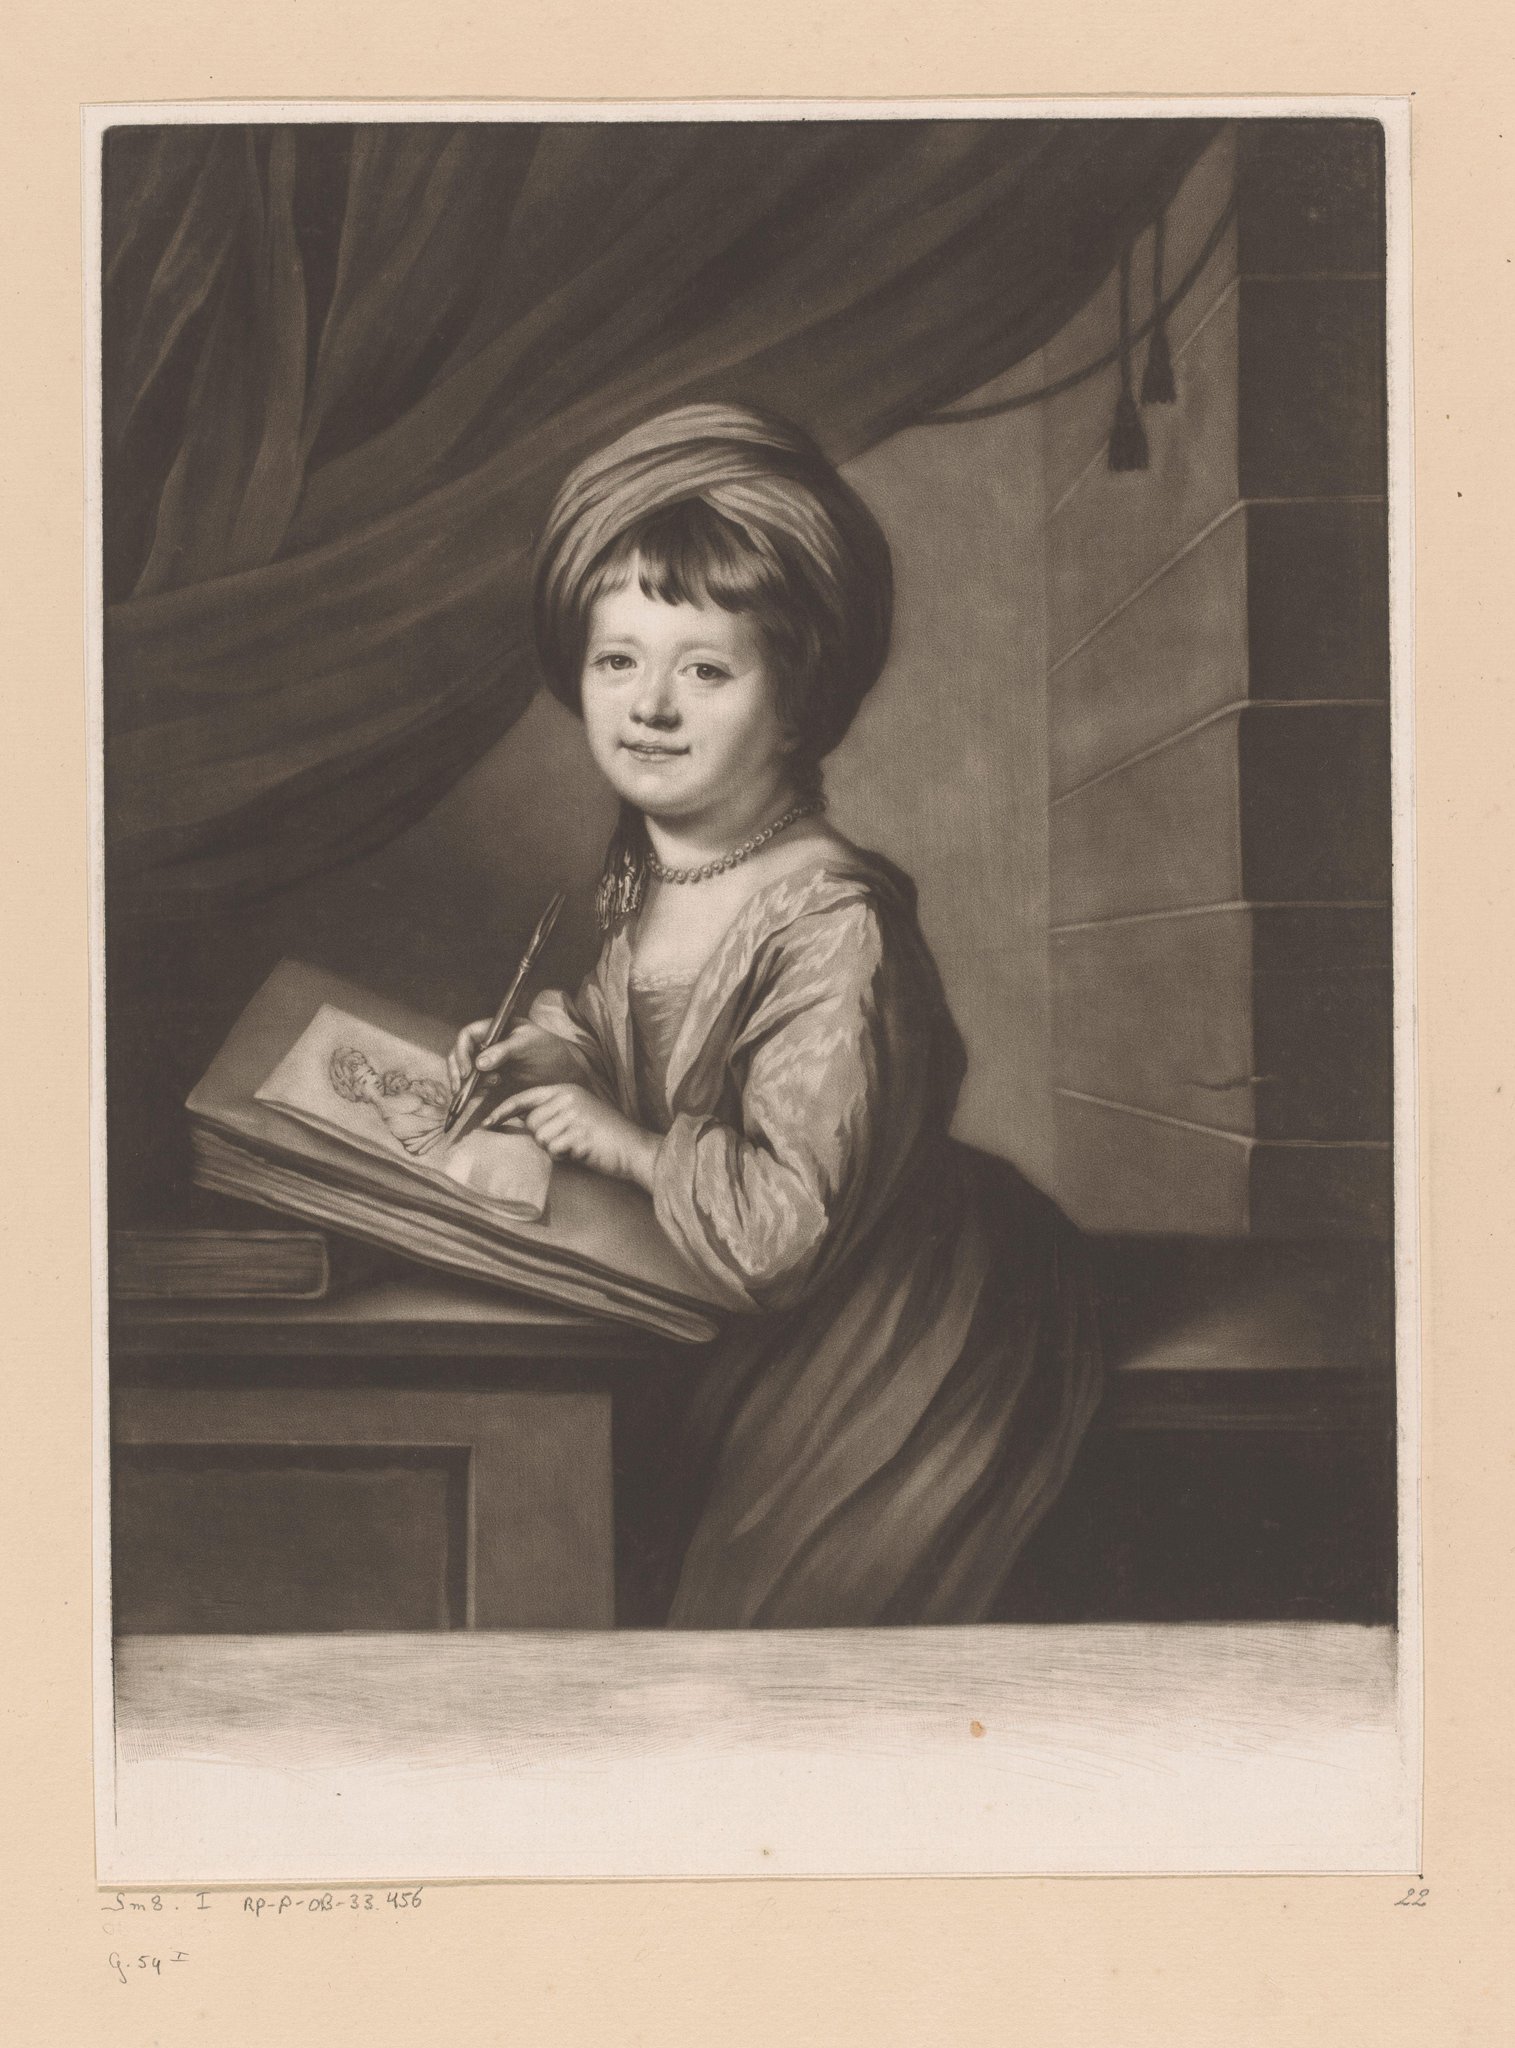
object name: print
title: Portret van Helena Beatson als kind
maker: james watson (prentmaker)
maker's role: print maker, publisher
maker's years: 1740-1790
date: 1768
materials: paper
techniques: mezzotint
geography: london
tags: painter, draughtsman, helena beatson, historical persons - bb - woman, draughtsman at work, girl (child between toddler and youth)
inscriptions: collector's mark: Lugt 240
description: Beatson maakt een tekening van een vrouw met kind.